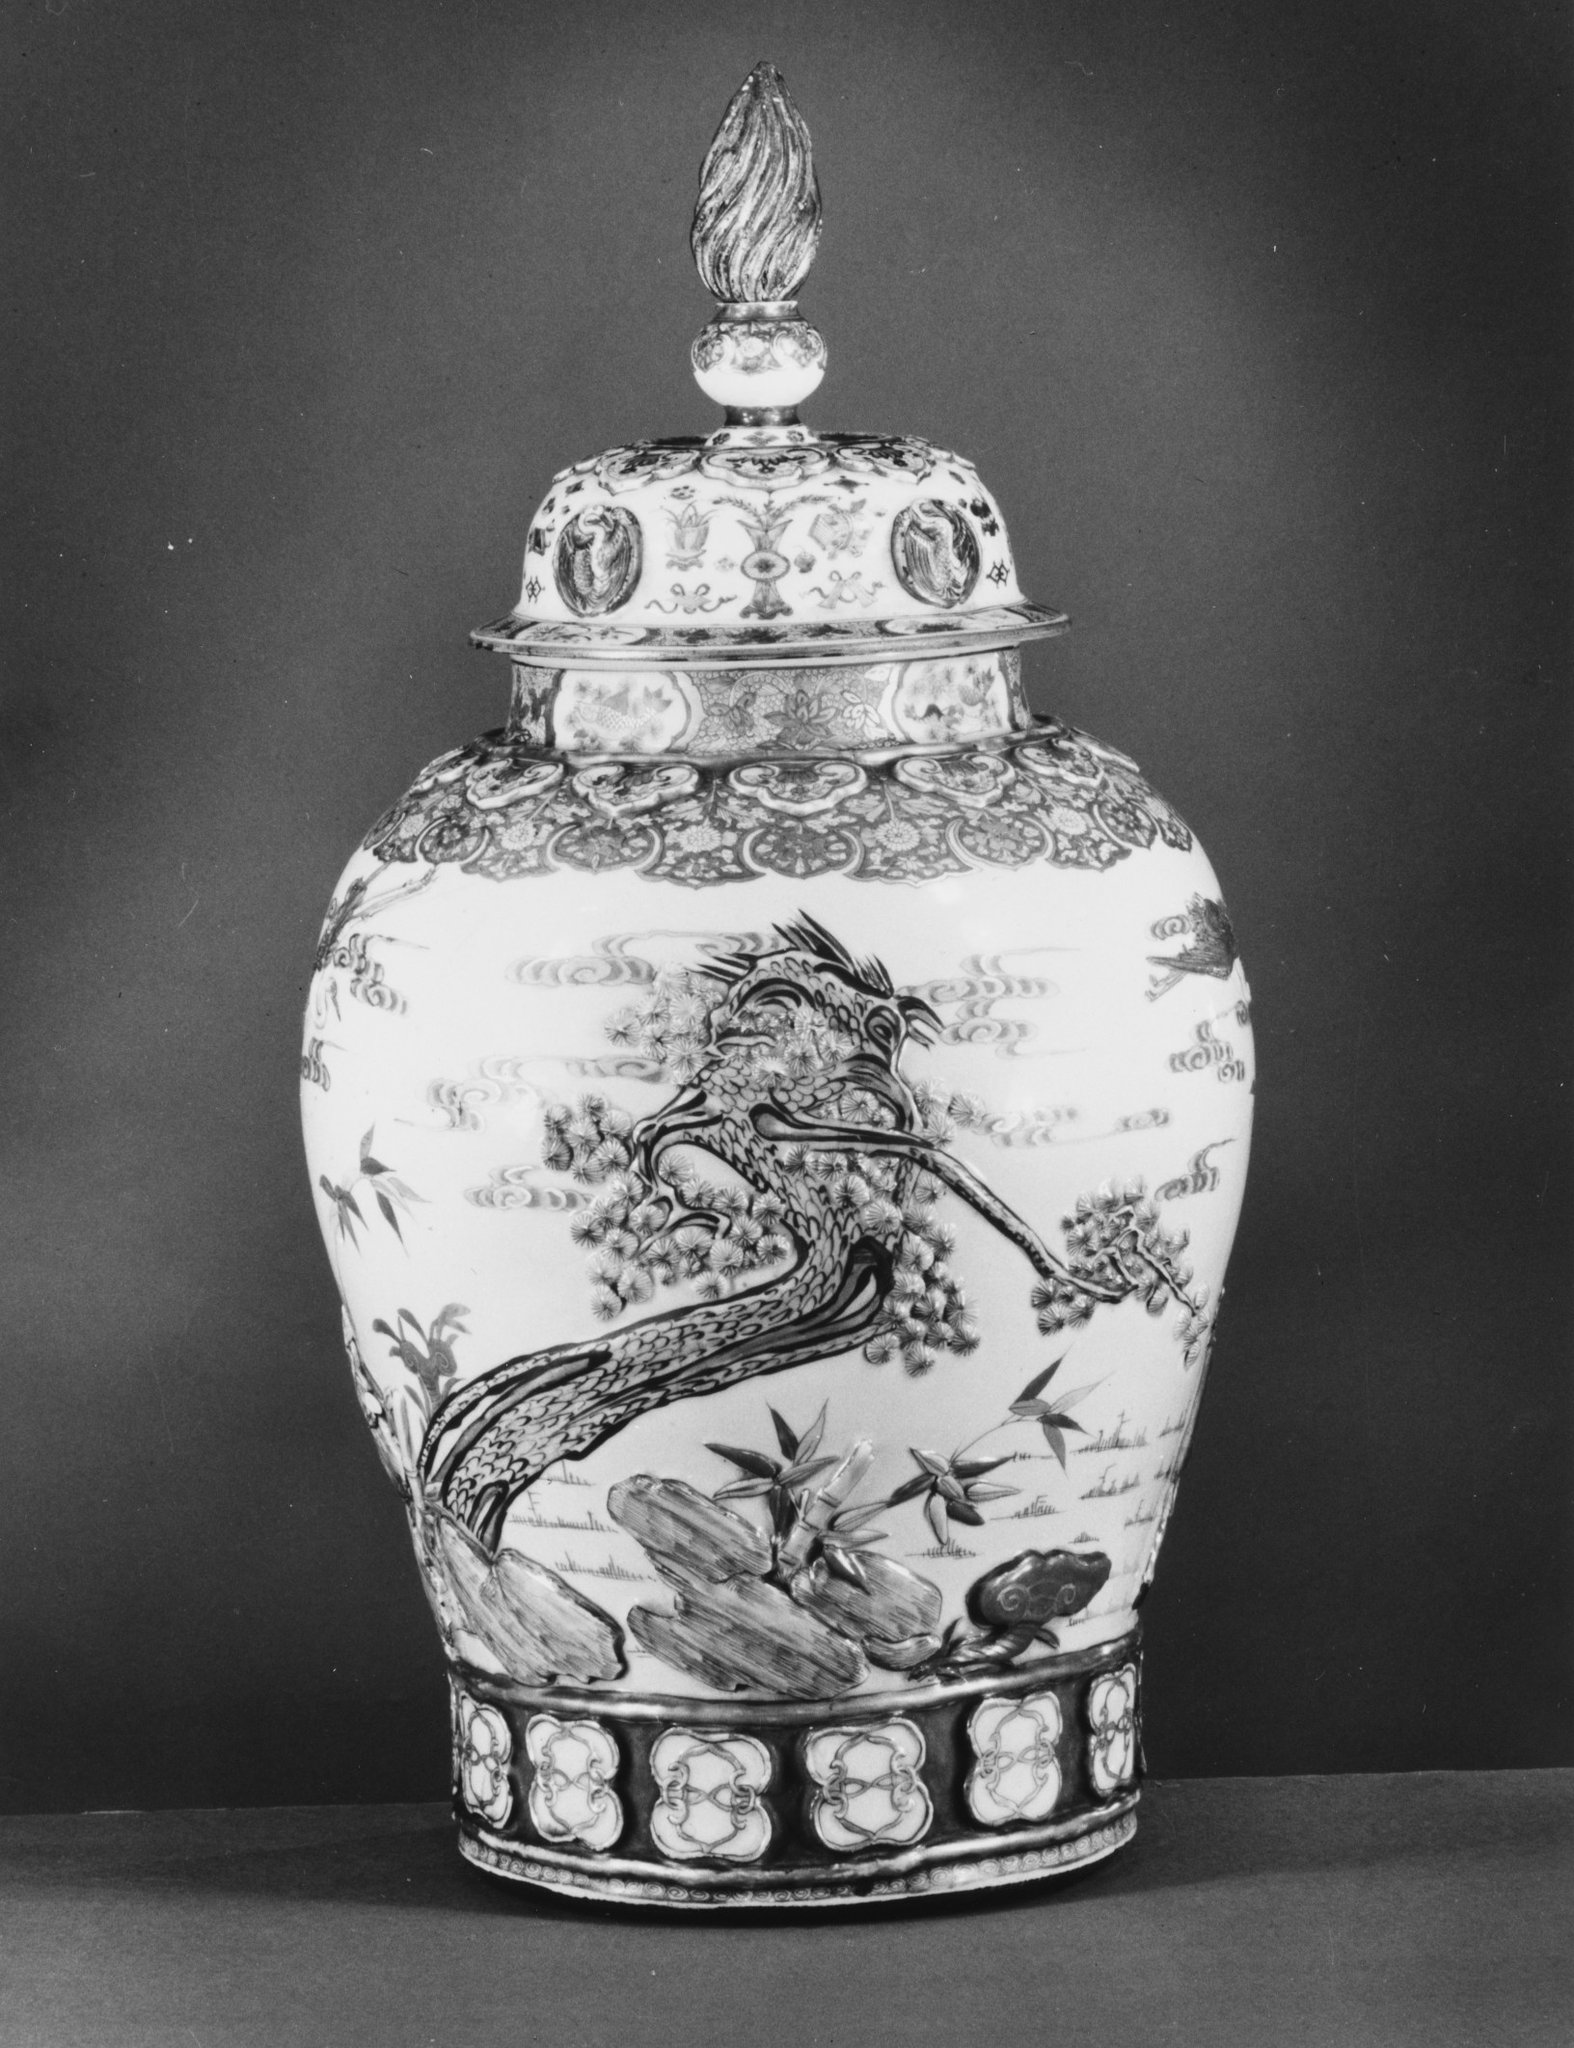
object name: hearth jar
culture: chinese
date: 1750-1790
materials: porcelain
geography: china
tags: trees